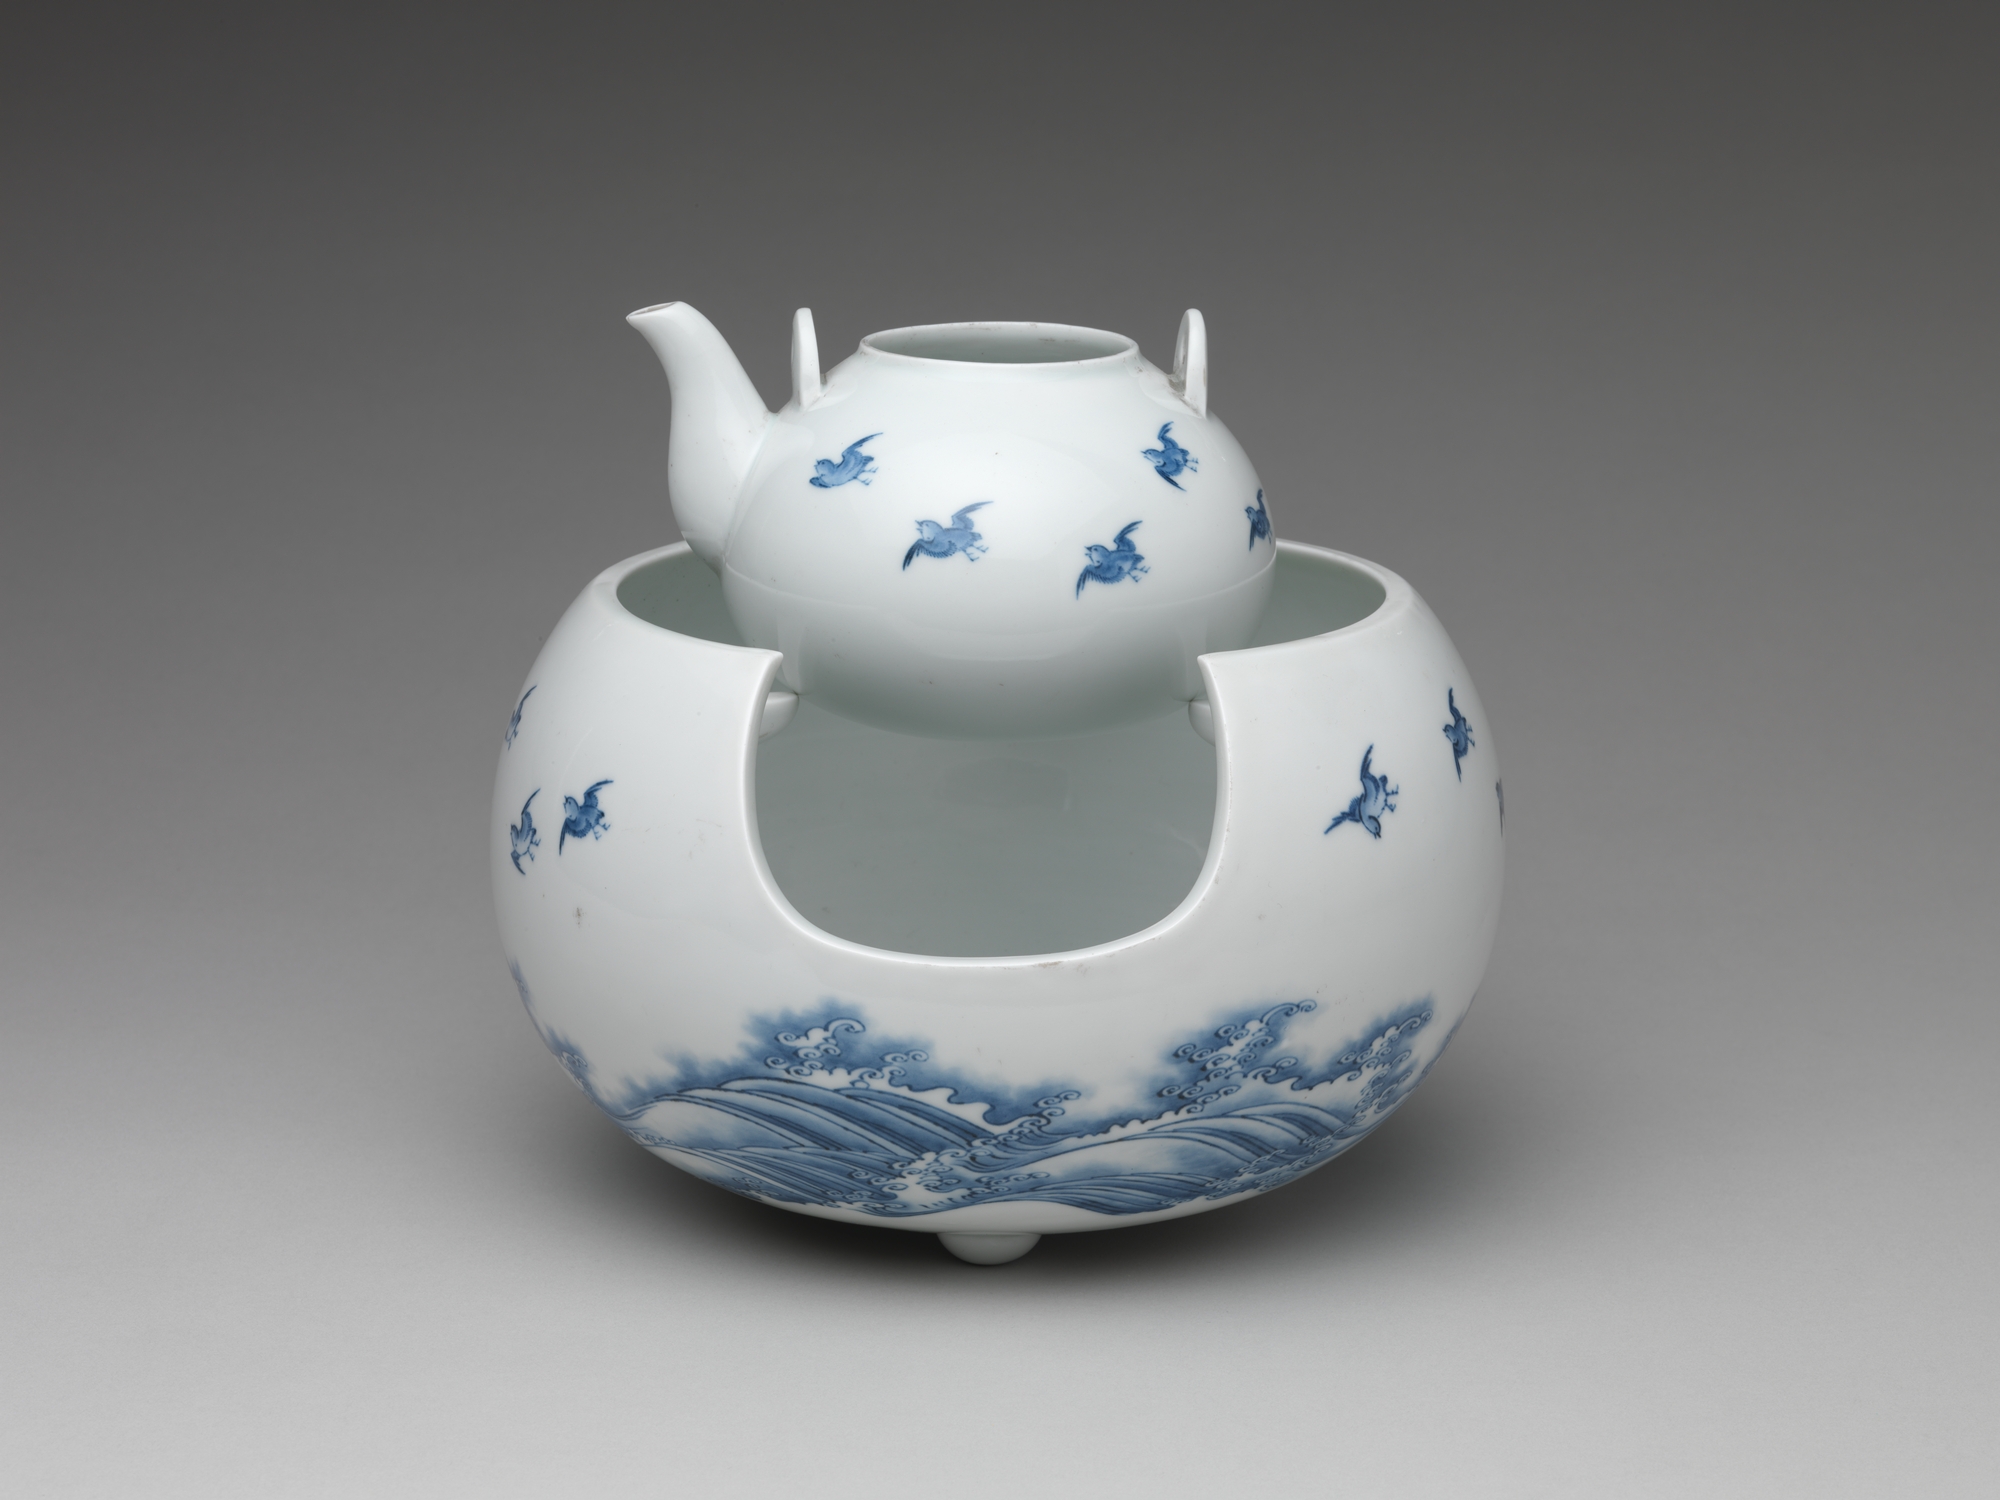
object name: teapot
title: Teapot and Brazier with Design of Birds Flying over Waves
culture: japanese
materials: porcelain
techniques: underglaze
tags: birds